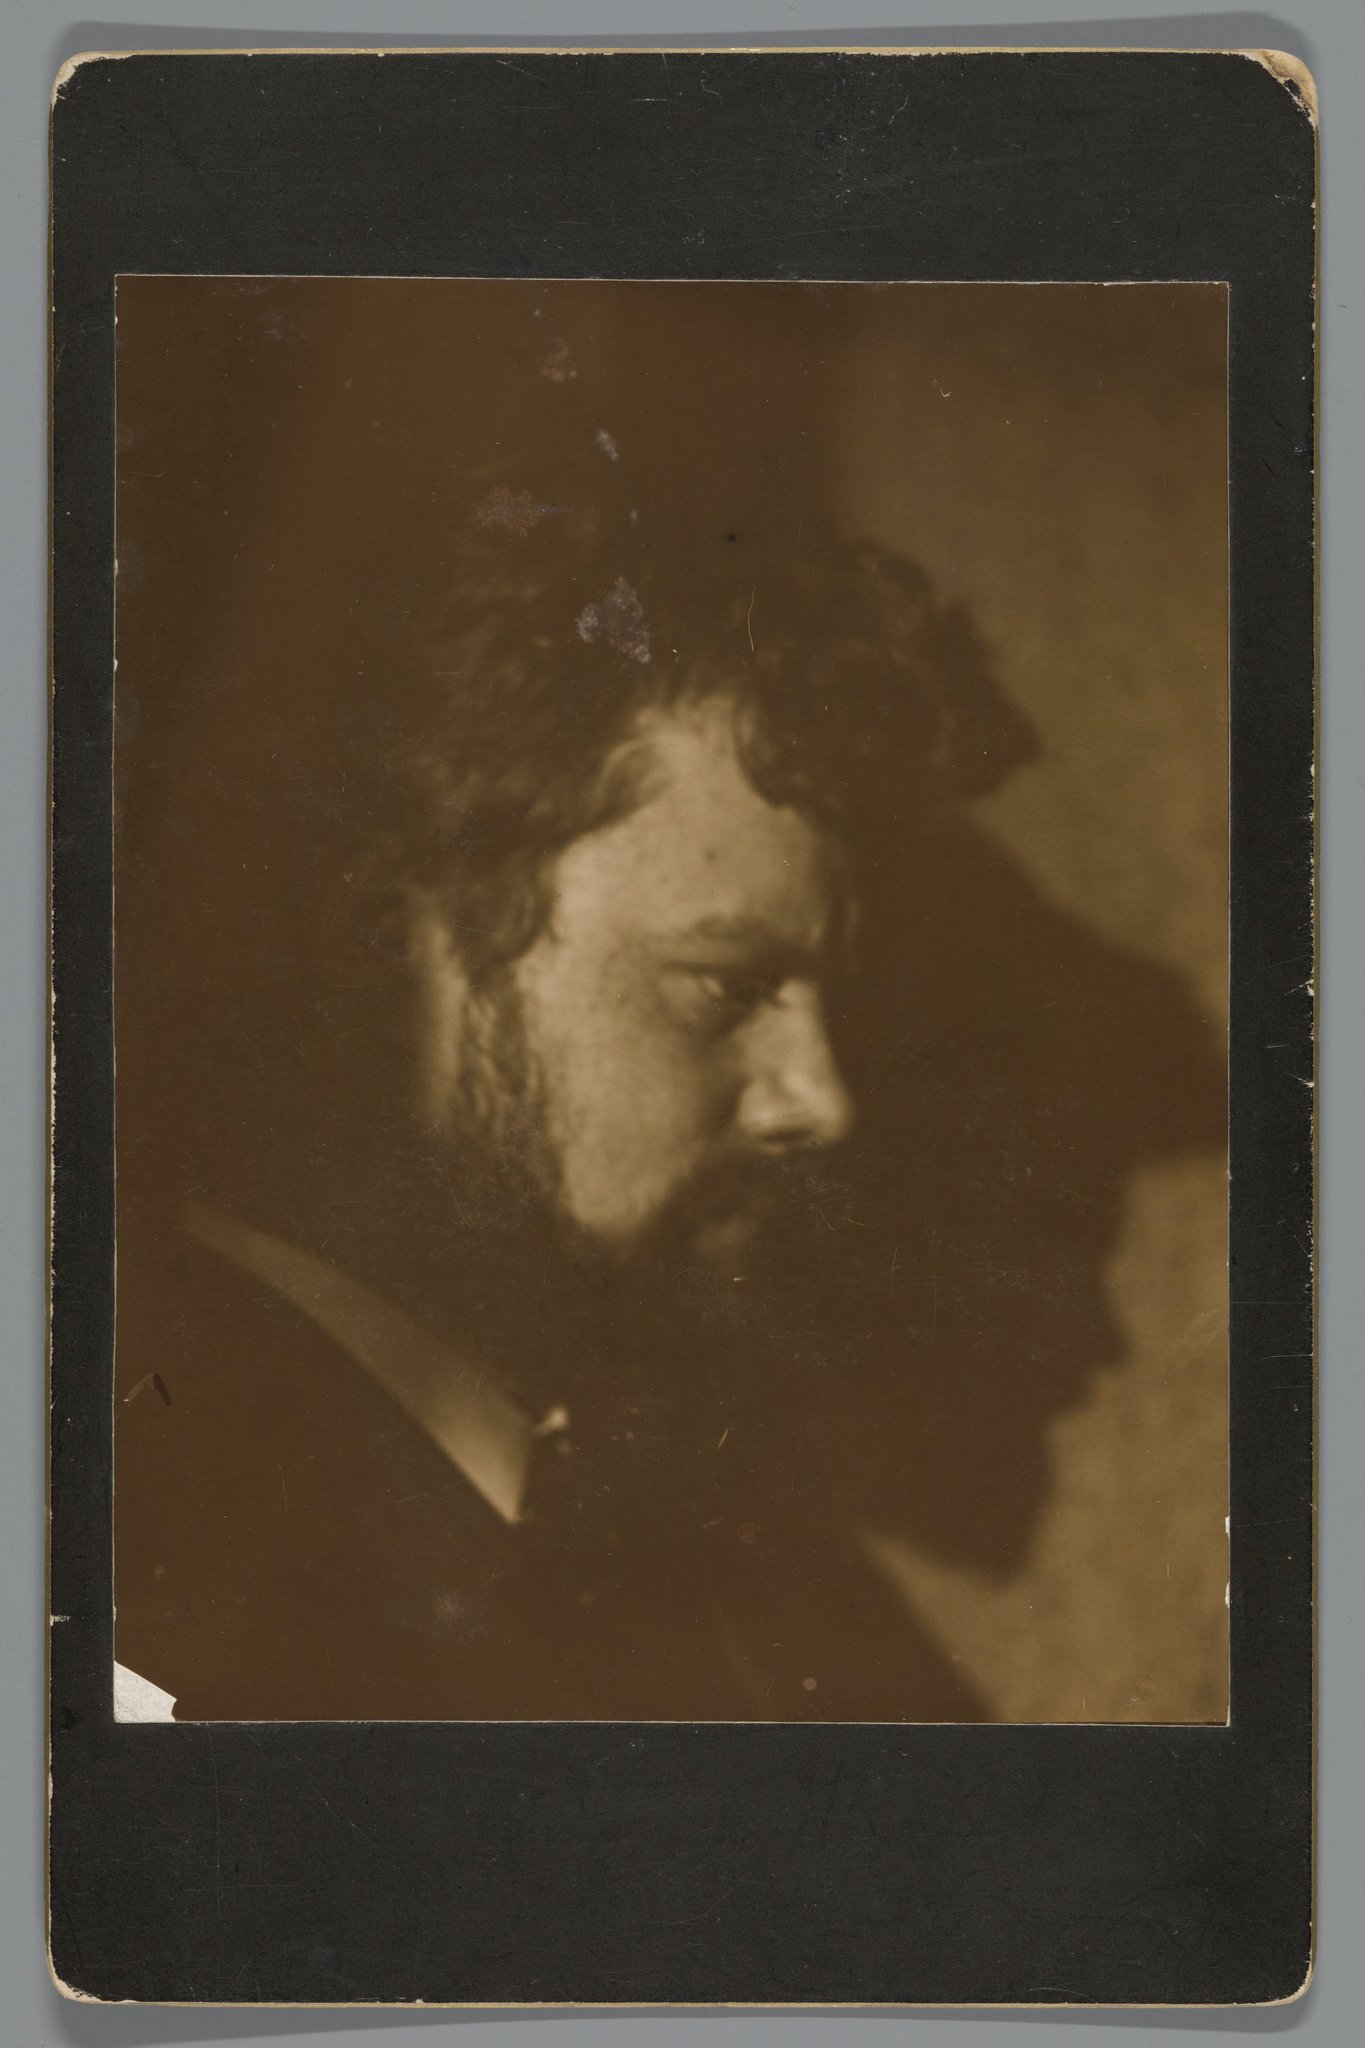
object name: photograph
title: Portraits of Lise Jordan, George Hendrik Breitner, Lise Jordan, Jaap Batavier, Hein Boeken, Paul Verlaine and Herman Gorter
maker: willem witsen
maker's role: draughtsman, painter, print maker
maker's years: 1860-1923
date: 1860-1915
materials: cardboard, paper, photographic support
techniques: gelatin silver print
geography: amsterdam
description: Witsen was a painter, etcher, and engraver of Amsterdam city views. The writers known as De Tachtigers (Literary Movement of Eighteen Eighties) and the artists’ models Marie and Lise Jordan met in his studio. In his free time Witsen photographed his friends in a way he had cribbed from Joseph Jessurun de Mesquita, who died young. He experimented endlessly, for instance with heads filling the picture plane and seen close up. He also managed to convince the French poet Verlaine to pose in front of his camera.